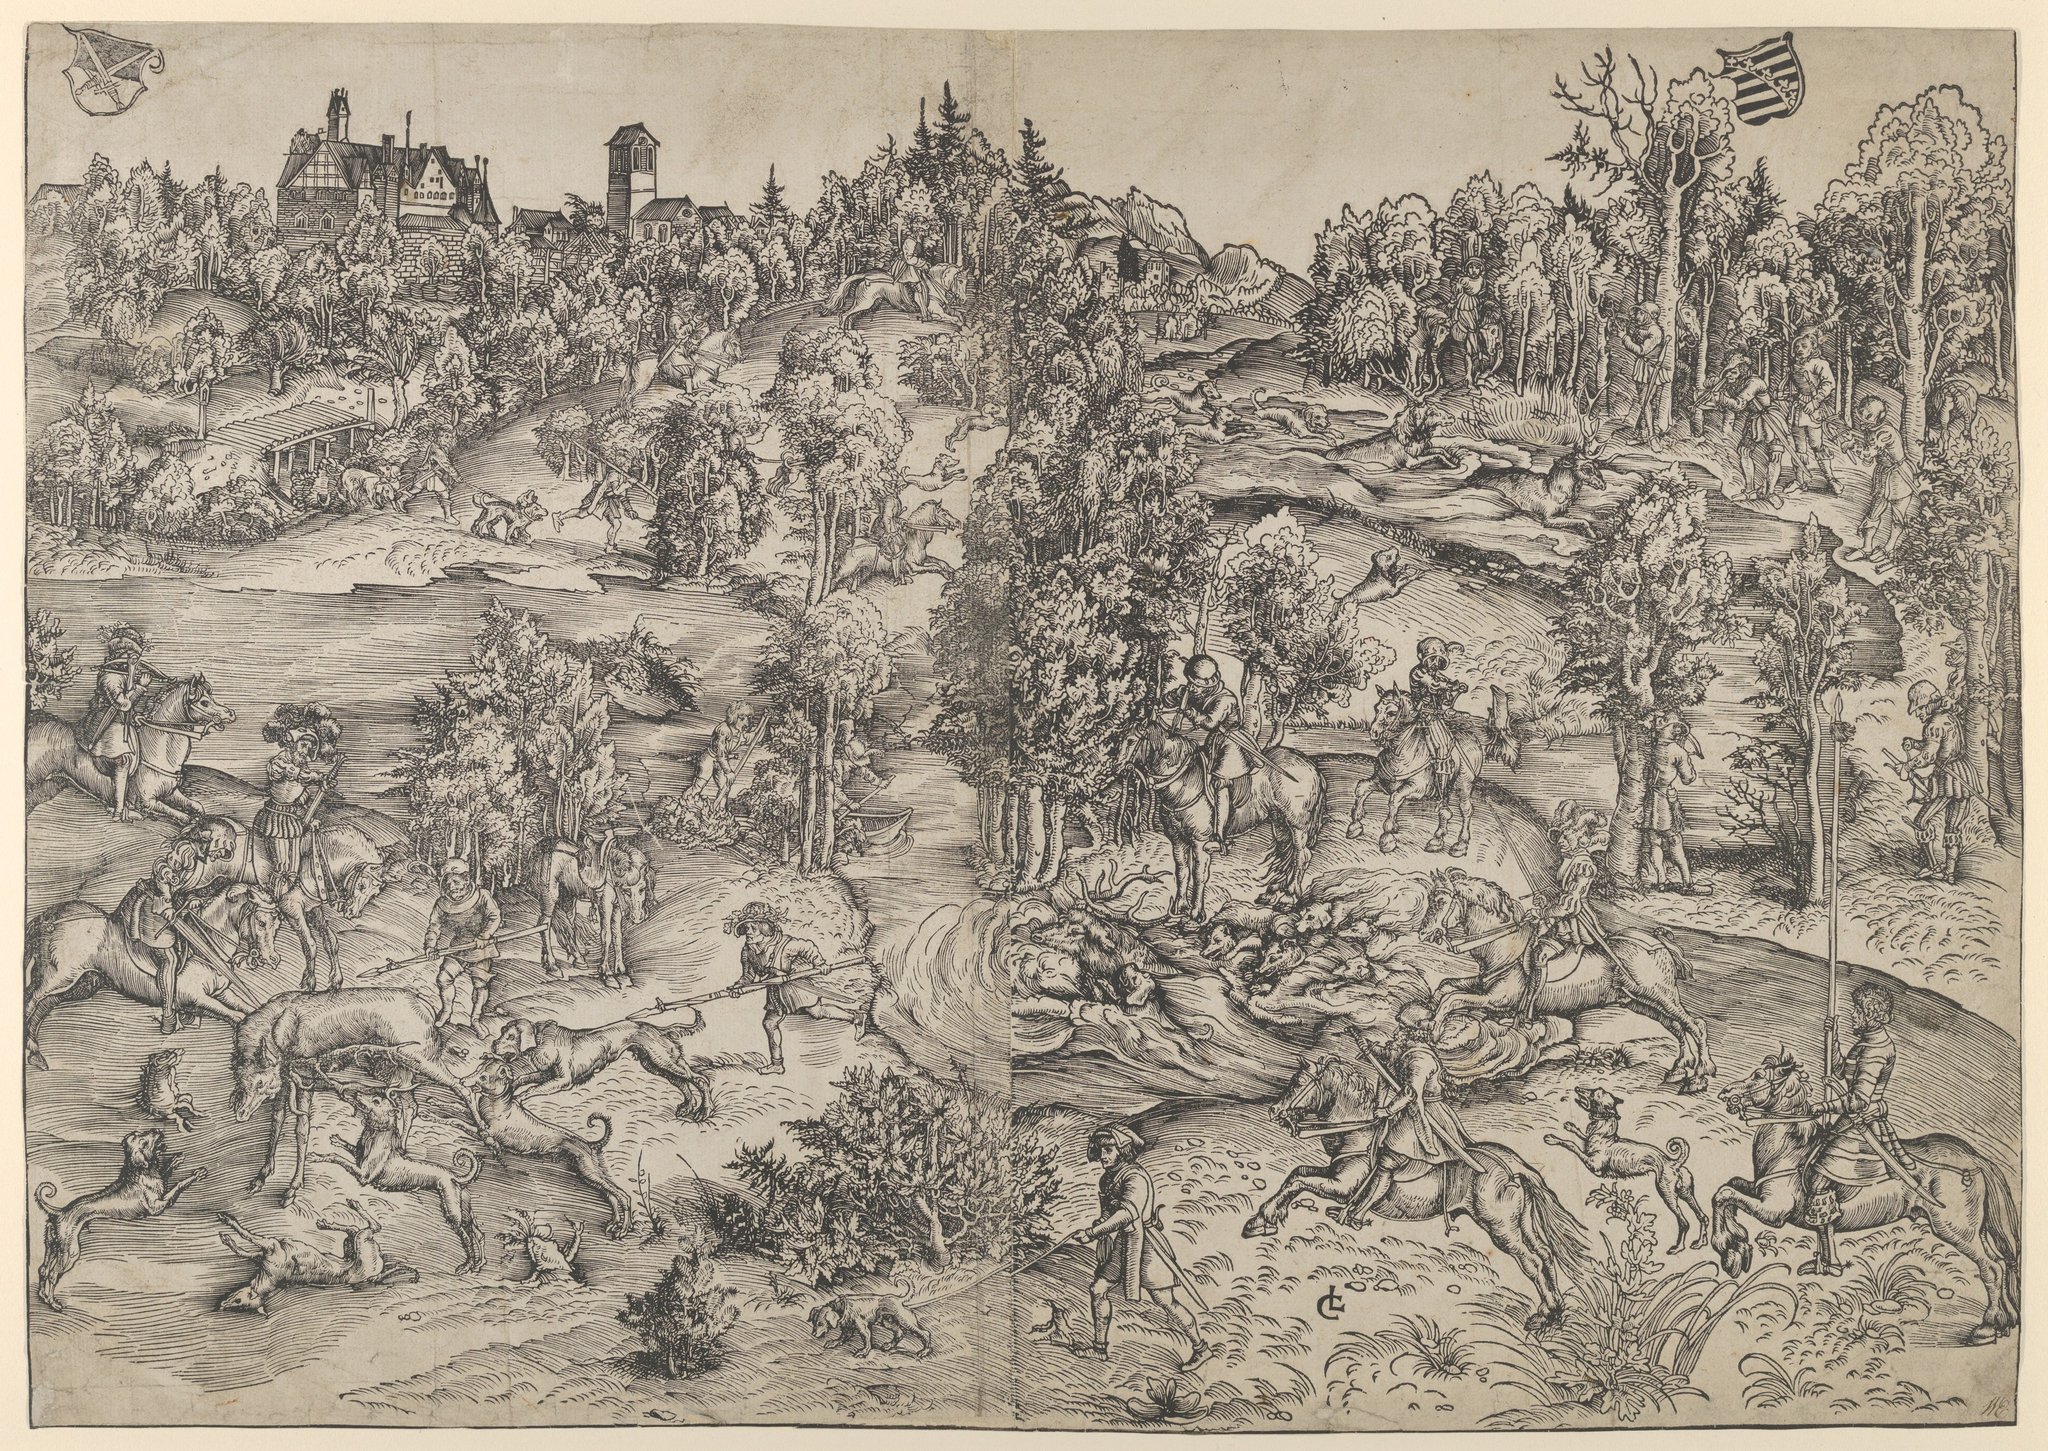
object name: print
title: The Stag-Hunt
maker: lucas cranach the elder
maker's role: artist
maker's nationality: german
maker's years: 1472-1553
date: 1506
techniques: woodcut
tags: soldiers,weapons,men,hunting,deer,dogs,rivers,landscapes,trees,coat of arms